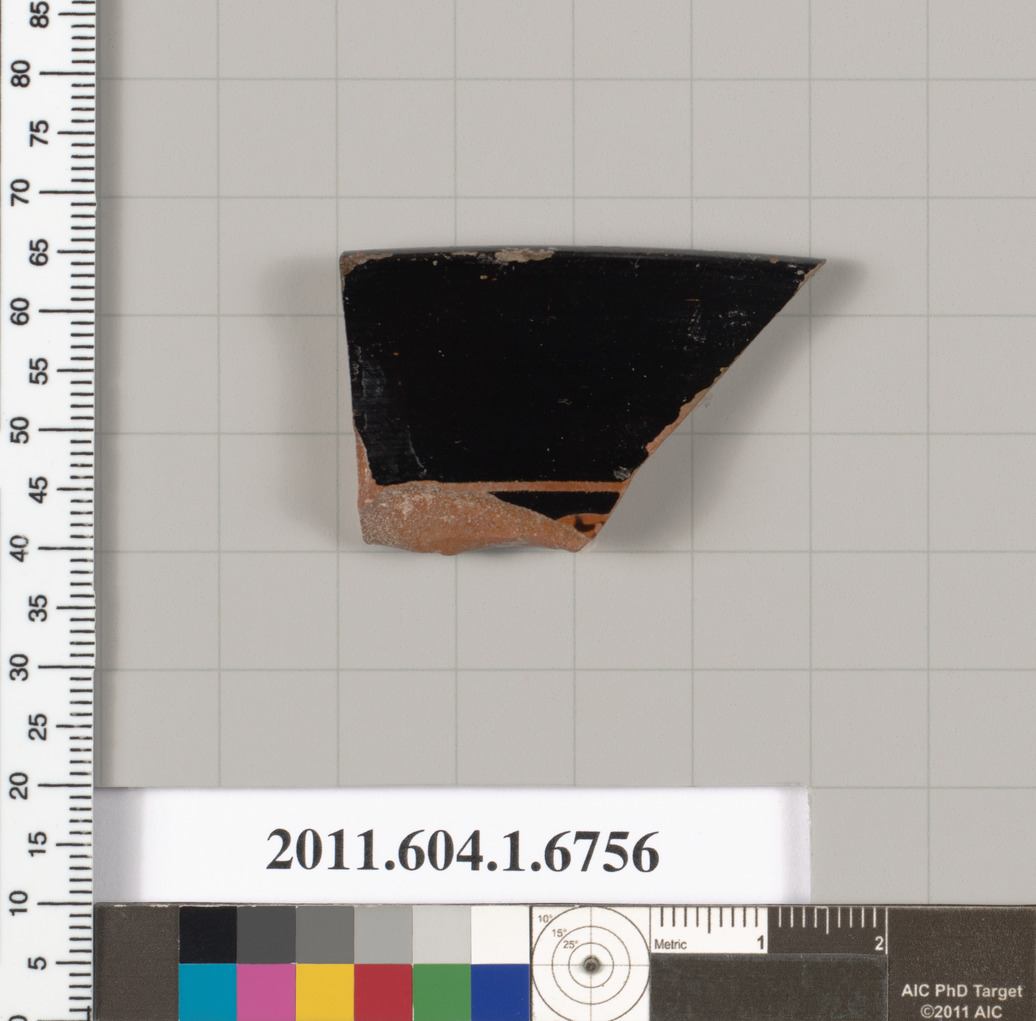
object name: kylix fragment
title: Terracotta rim fragment of a kylix (drinking cup)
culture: greek, attic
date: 490-470 BCE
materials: terracotta